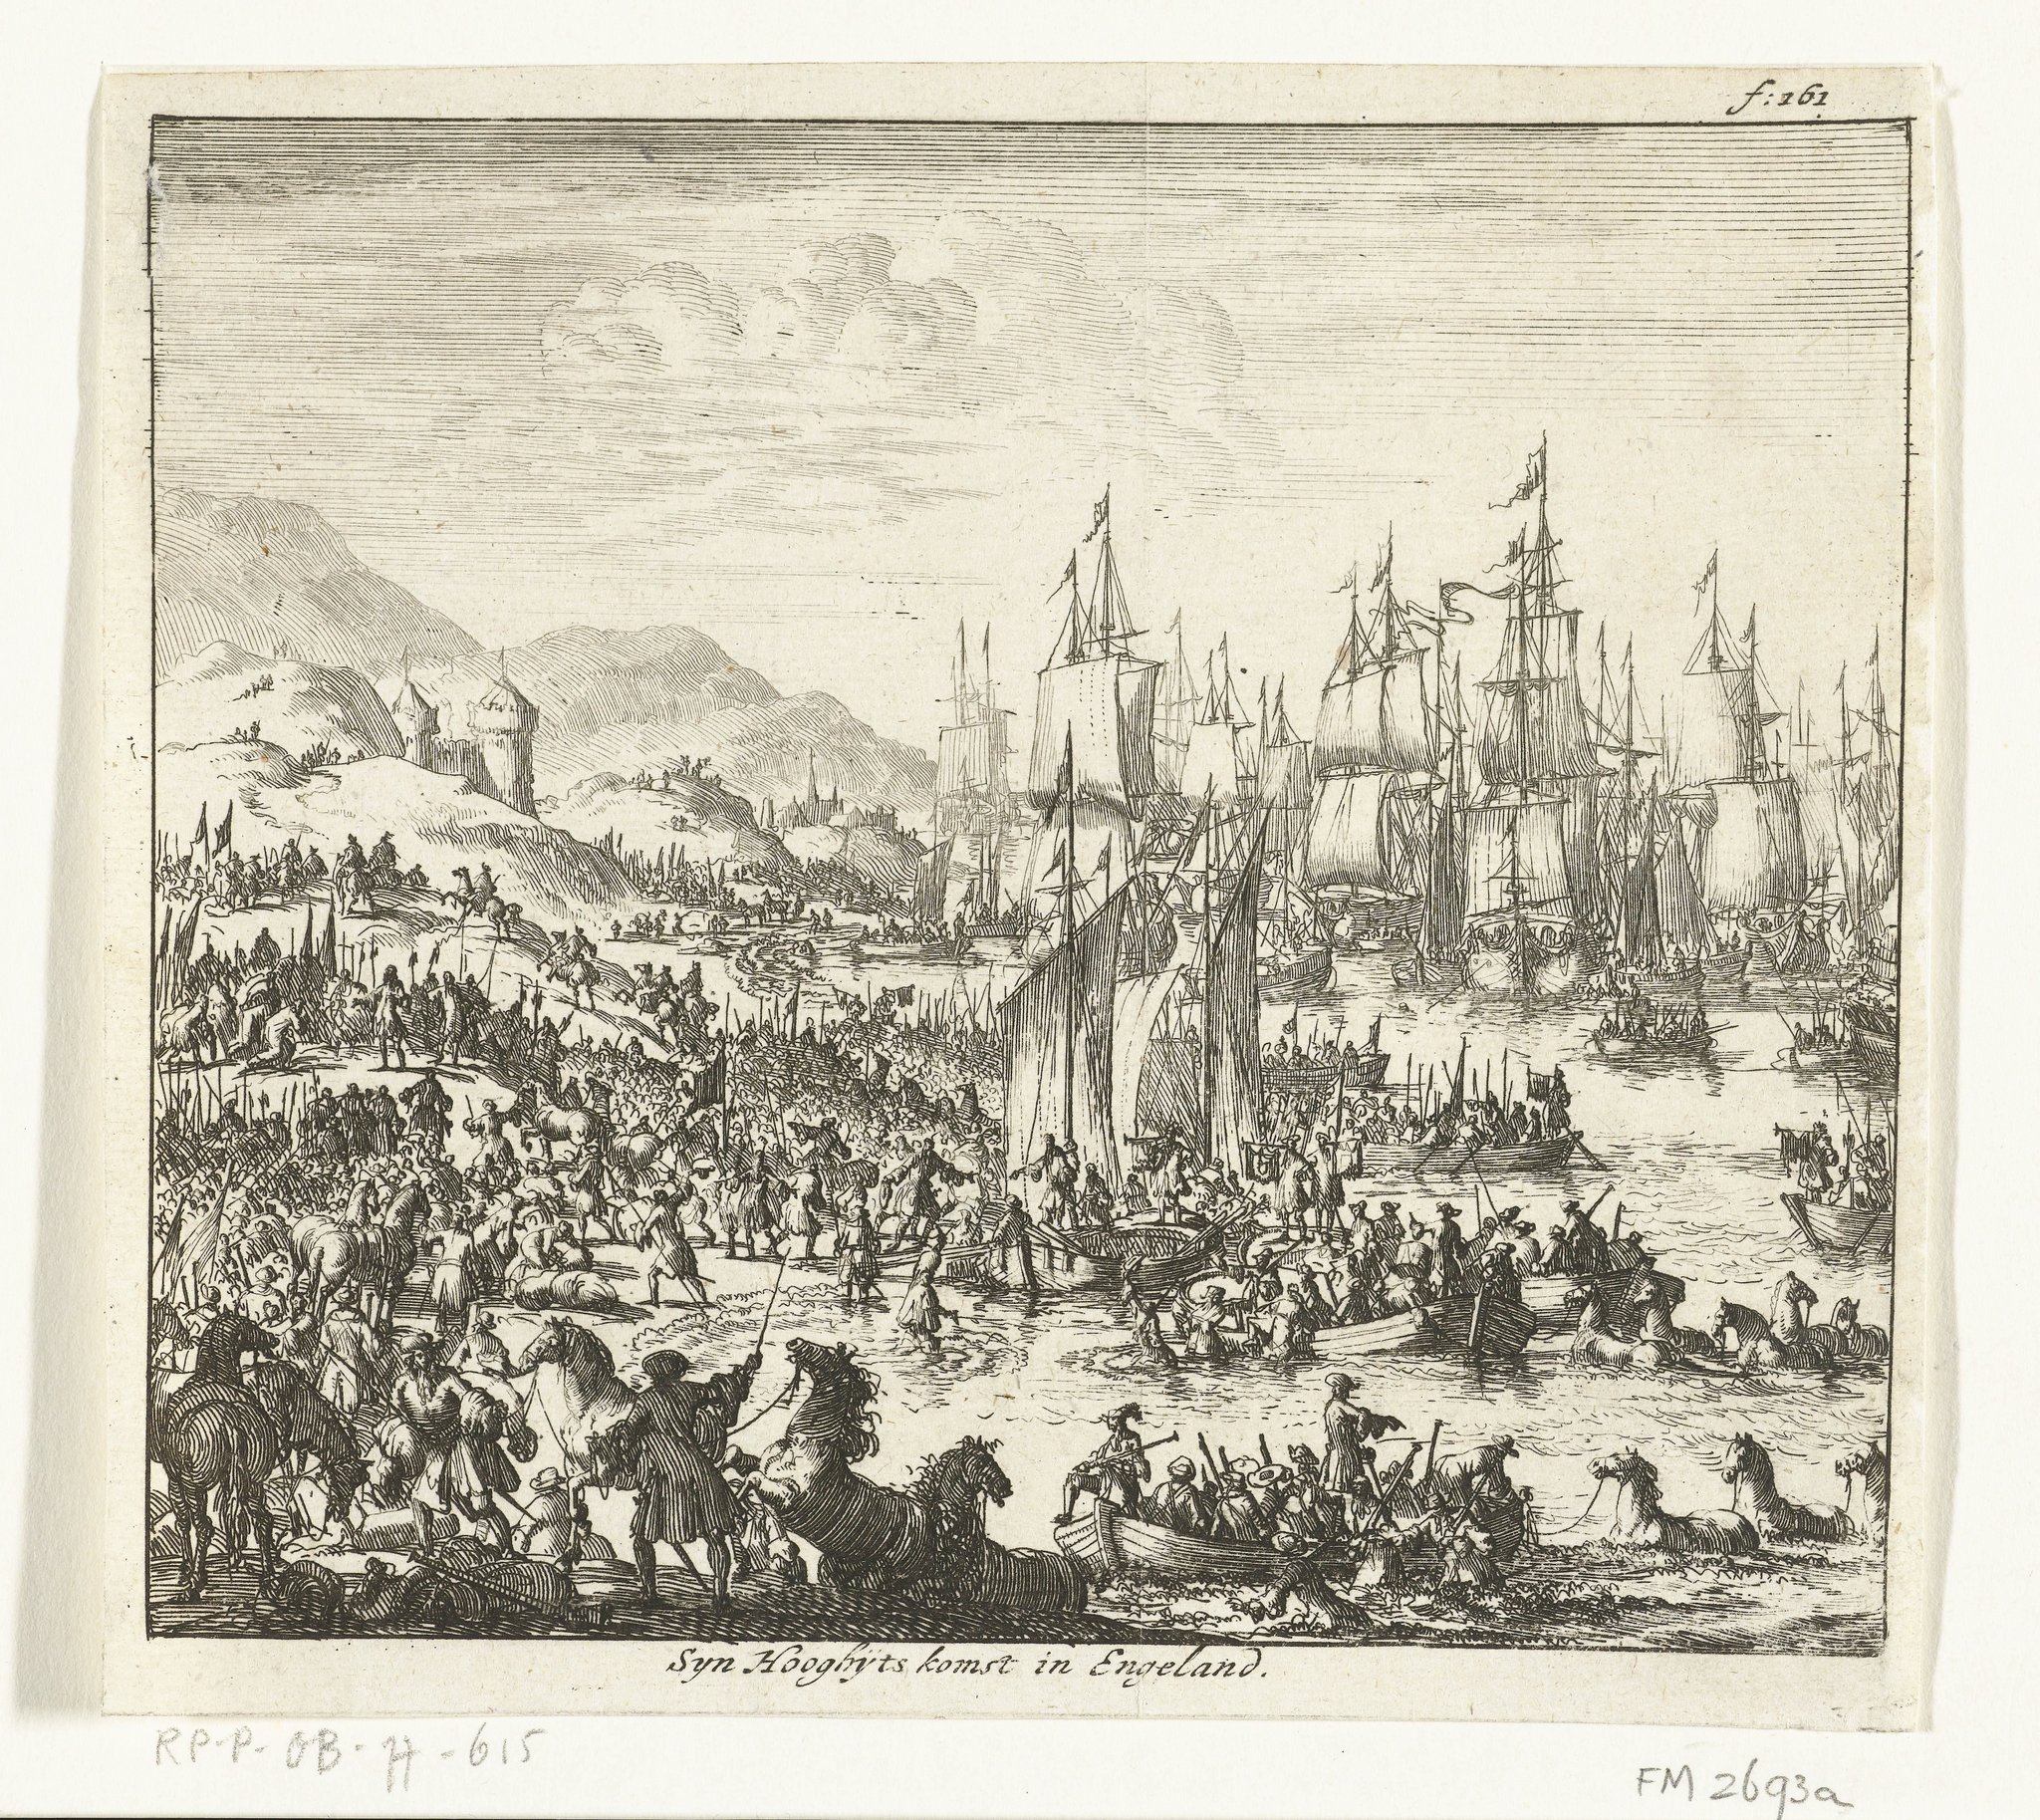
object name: print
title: Aankomst van Willem III te Engeland, 1688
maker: jan luyken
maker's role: draughtsman, print maker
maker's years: 1649-1712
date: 1689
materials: paper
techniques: etching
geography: northern netherlands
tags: william iii (prince of orange and king of england, scotland, and ireland), arrival and return ~ travelling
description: Gebruikt als illustratie in: Baltes Boekholt, Kort vertoog van Hollands bloedige oorlogen, Baltes Boekholt, Amsterdam 1689.